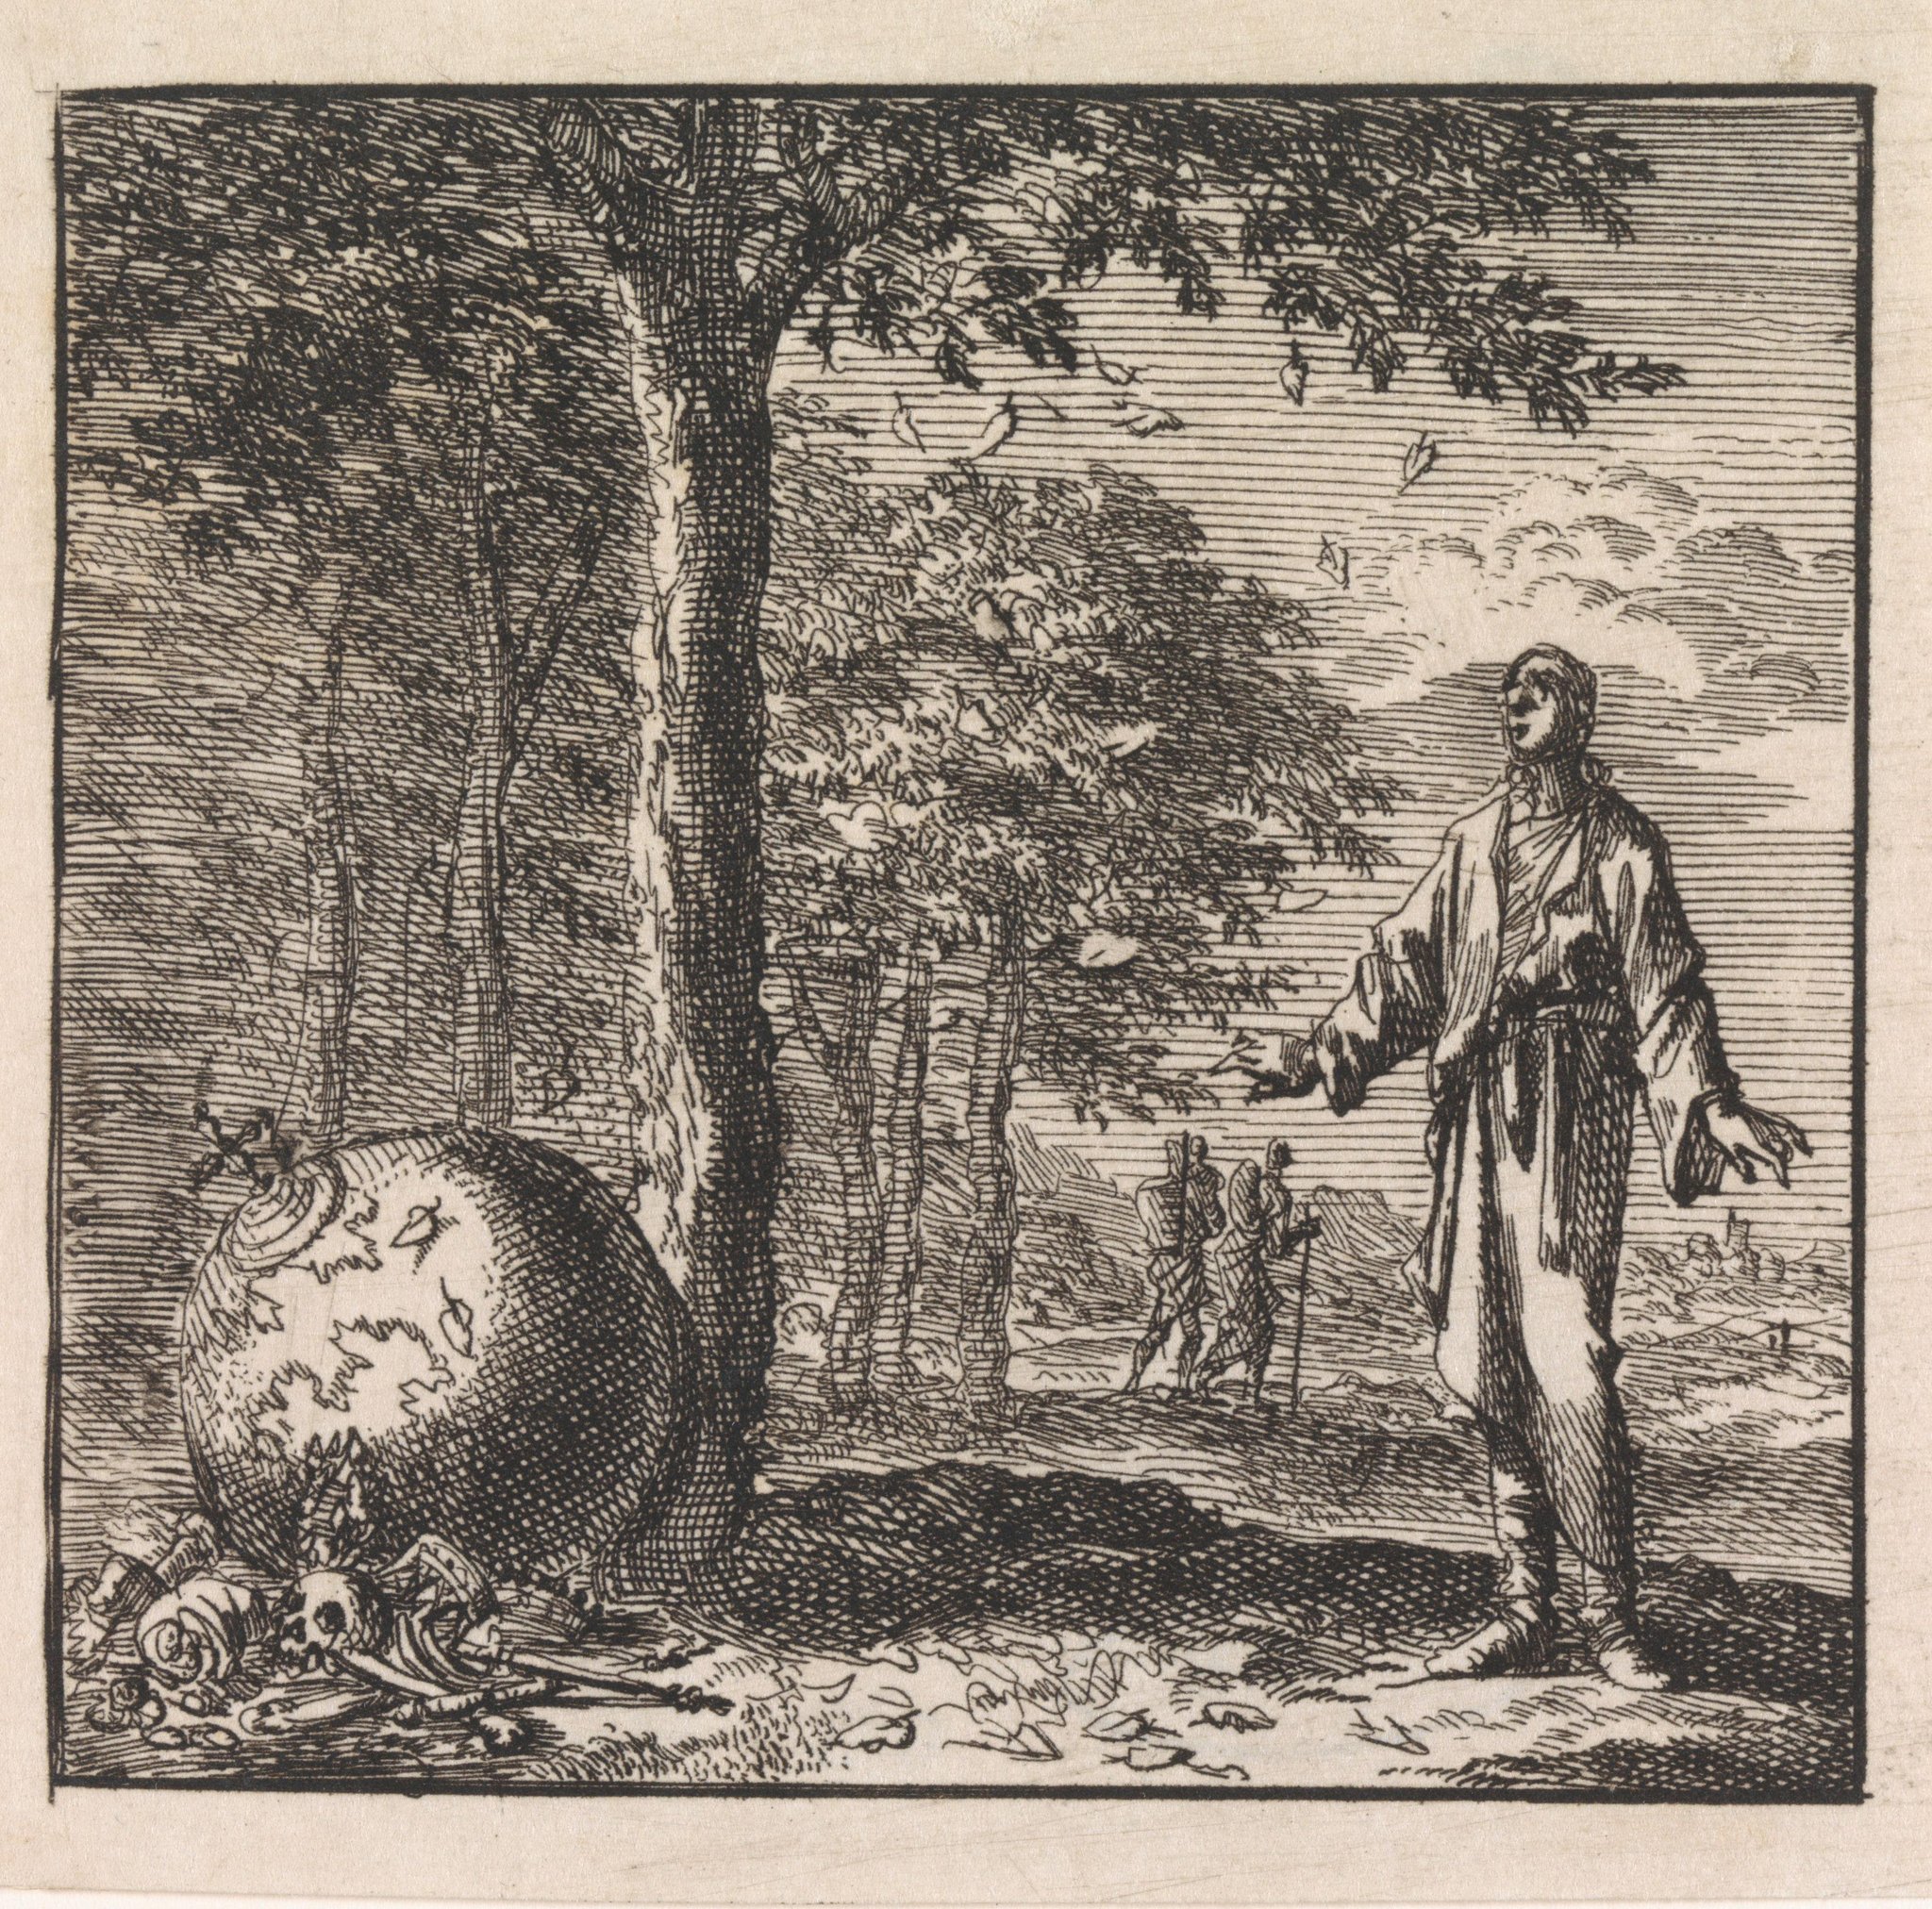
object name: print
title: Man ziet hoe een boom zijn bladeren verliest en bij de stam de wereld temidden van gebeente ligt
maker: jan luyken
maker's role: draughtsman, print maker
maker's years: 1649-1712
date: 1710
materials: paper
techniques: etching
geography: amsterdam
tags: earth, world as celestial body, 'vanitas' symbols, forest, wood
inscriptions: collector's mark: Lugt 2228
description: Proefdruk voor illustratie uit: Luyken, Jan. De onwaardige wereld, vertoond in vyftig zinnebeelden, met godlyke spreuken en stichtelyke verzen. Amsterdam: Pieter Arentsz. II (wed.) en Cornelis van der Sys, 1710, p. 192.